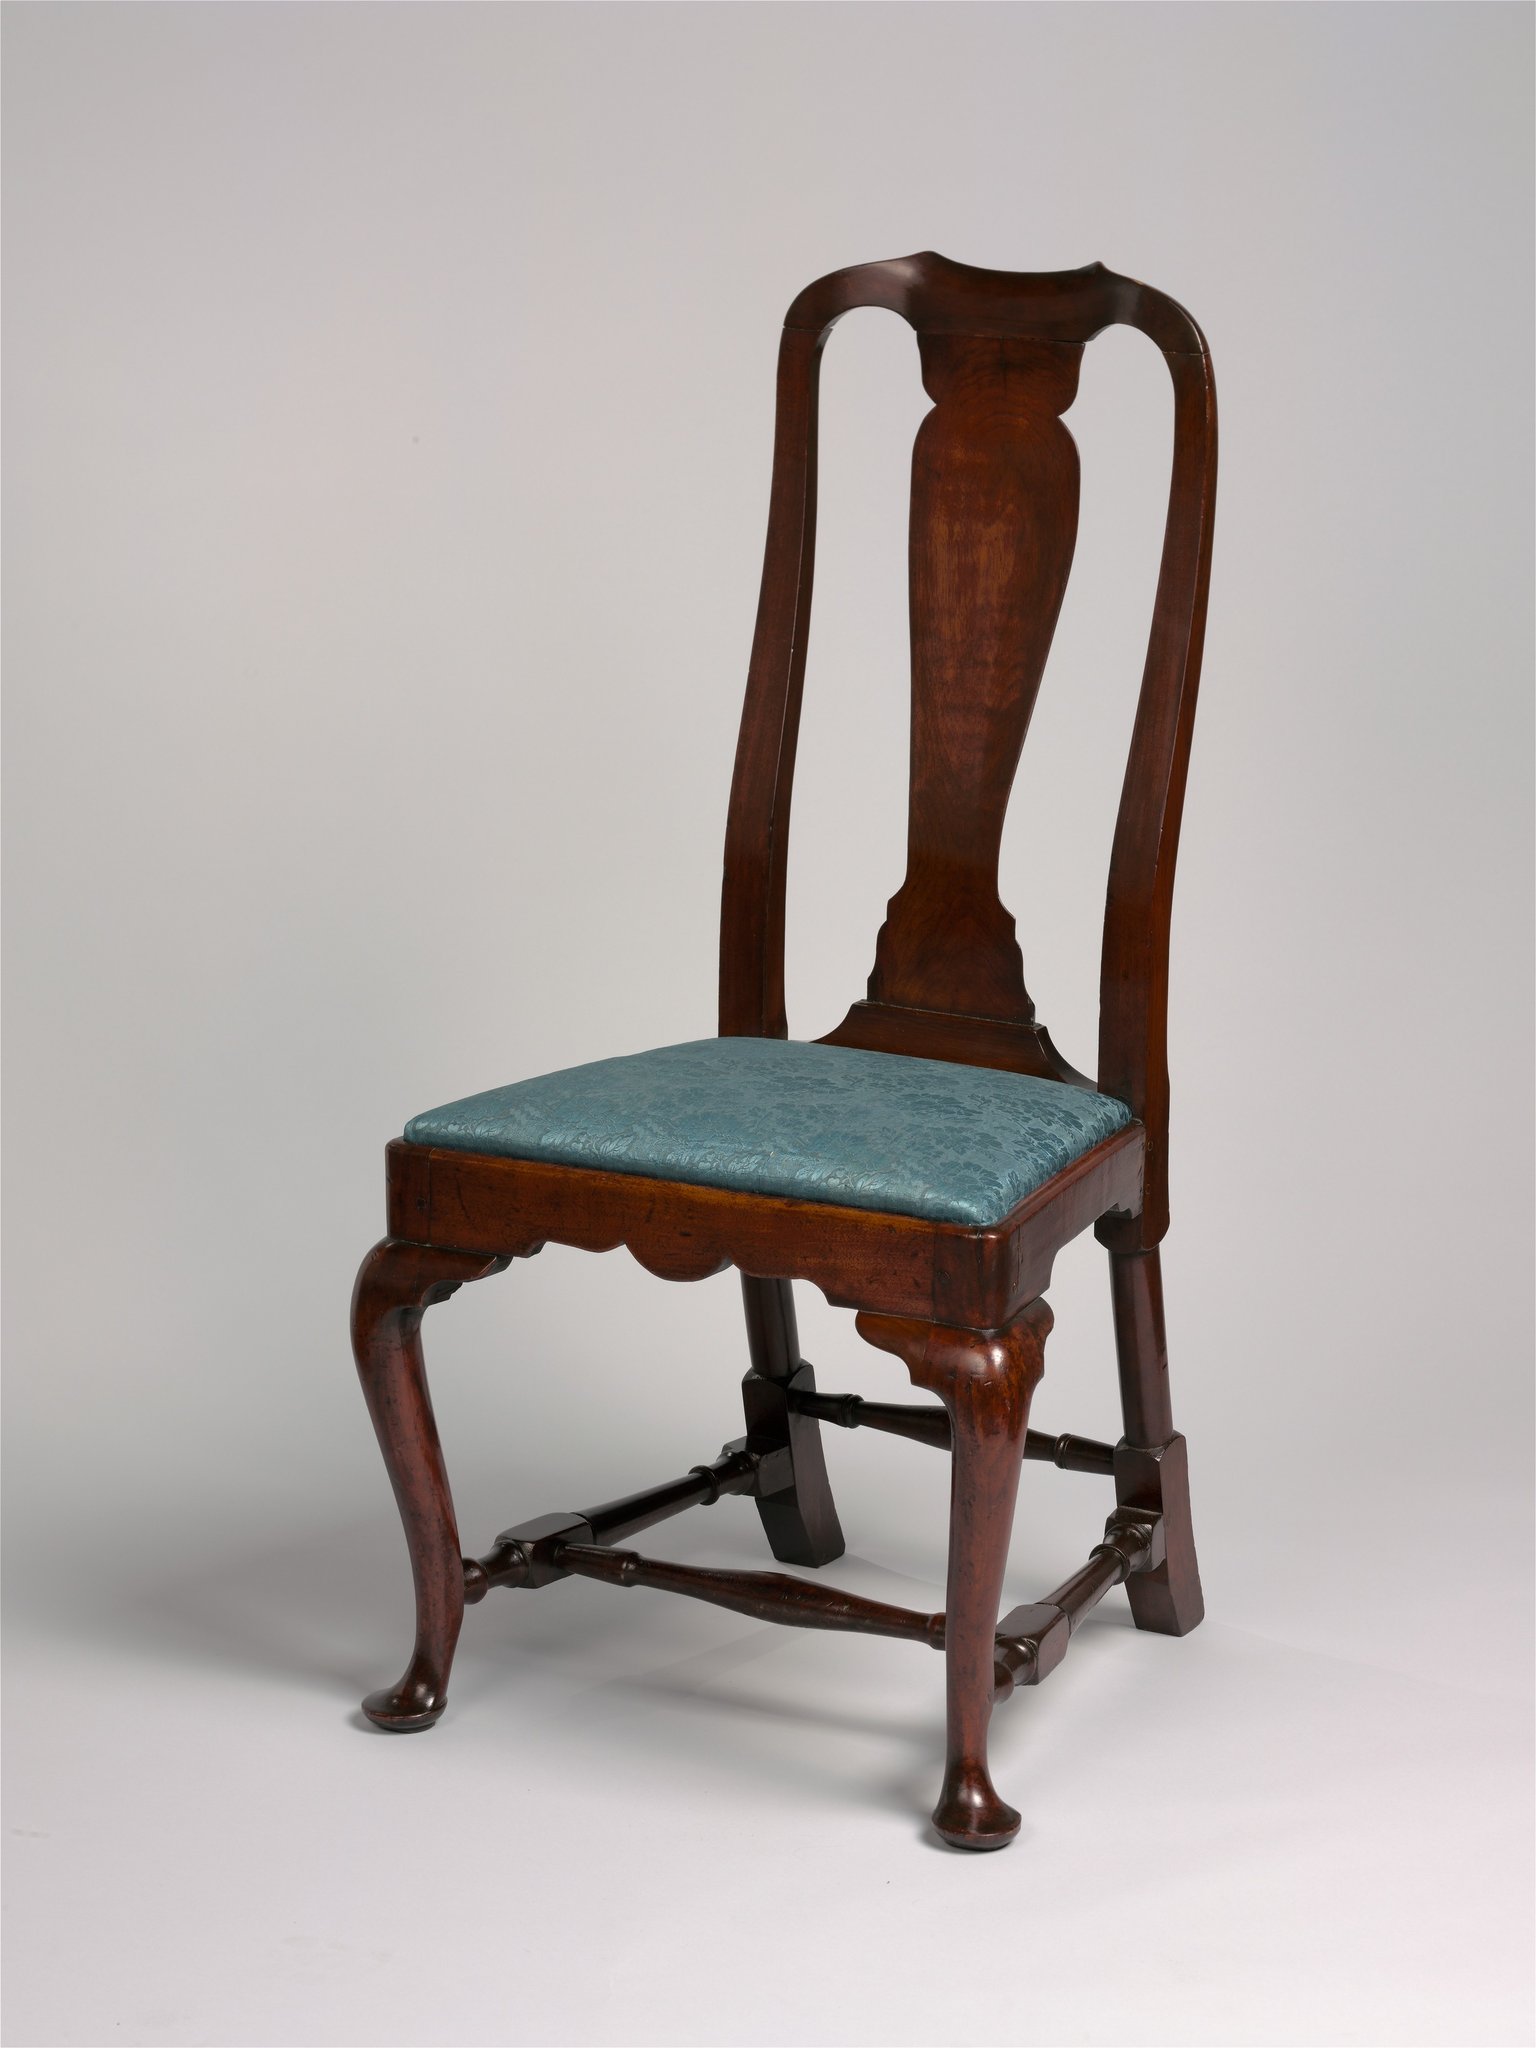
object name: side chair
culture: american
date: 1730-1790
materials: wood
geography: united states